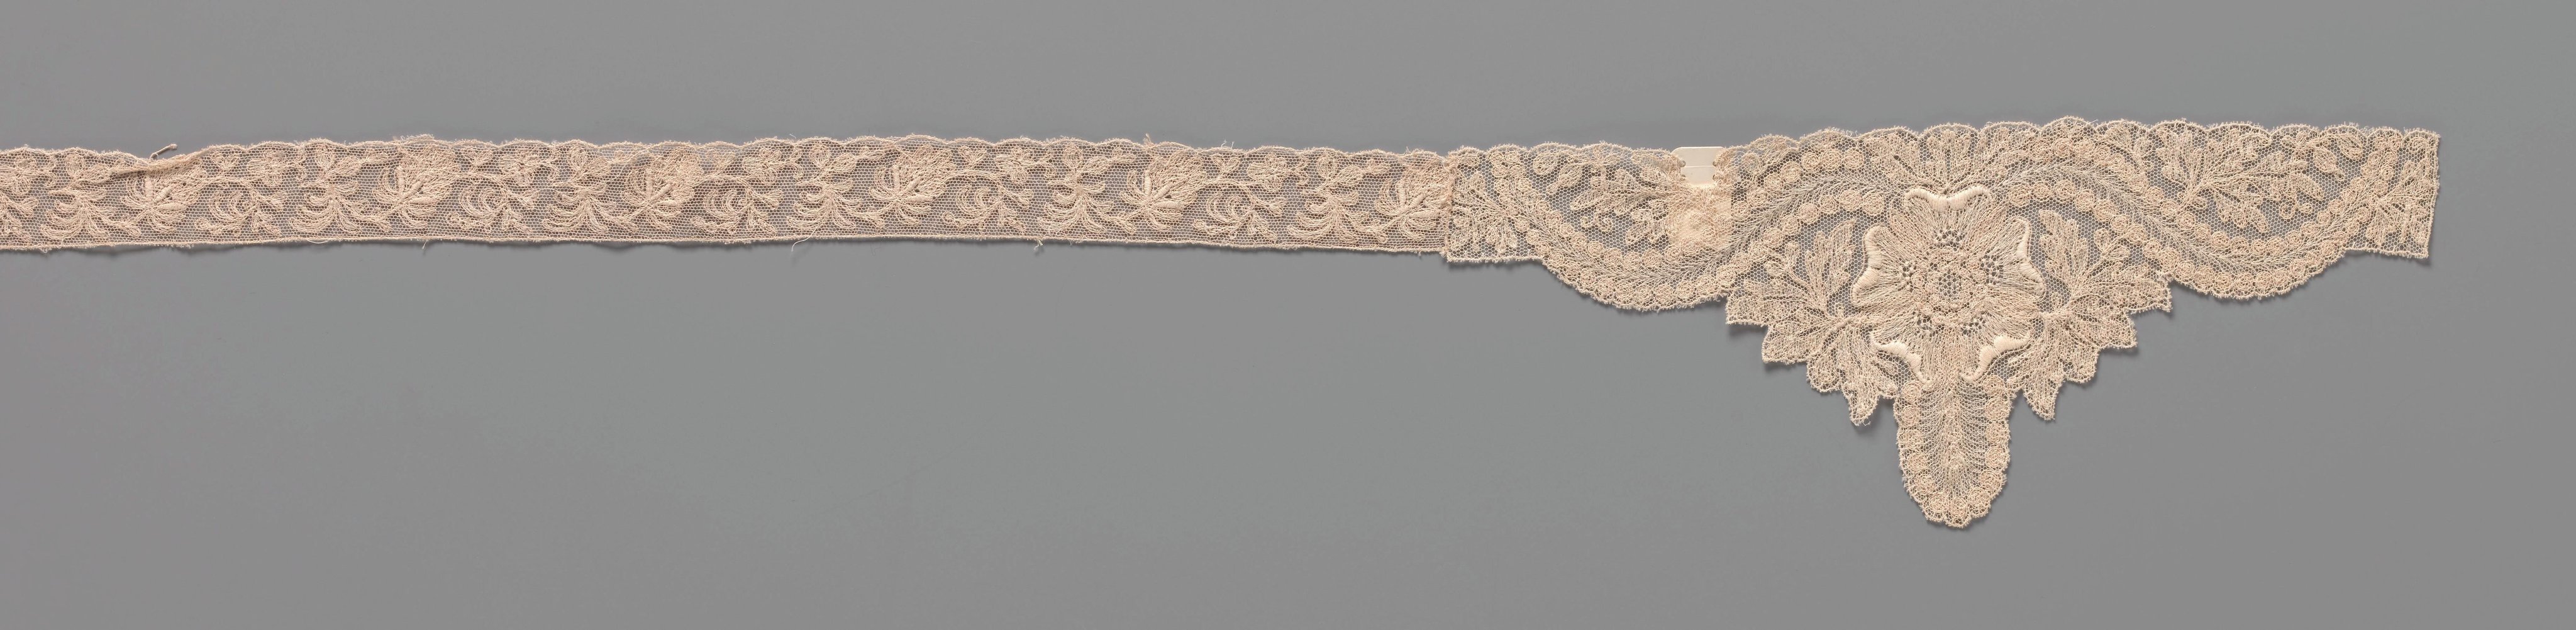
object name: belegstuk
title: Hemdapplicatie van roze machinale kant met bloem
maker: Anonymous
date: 1920-1930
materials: cotton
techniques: lace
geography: netherlands